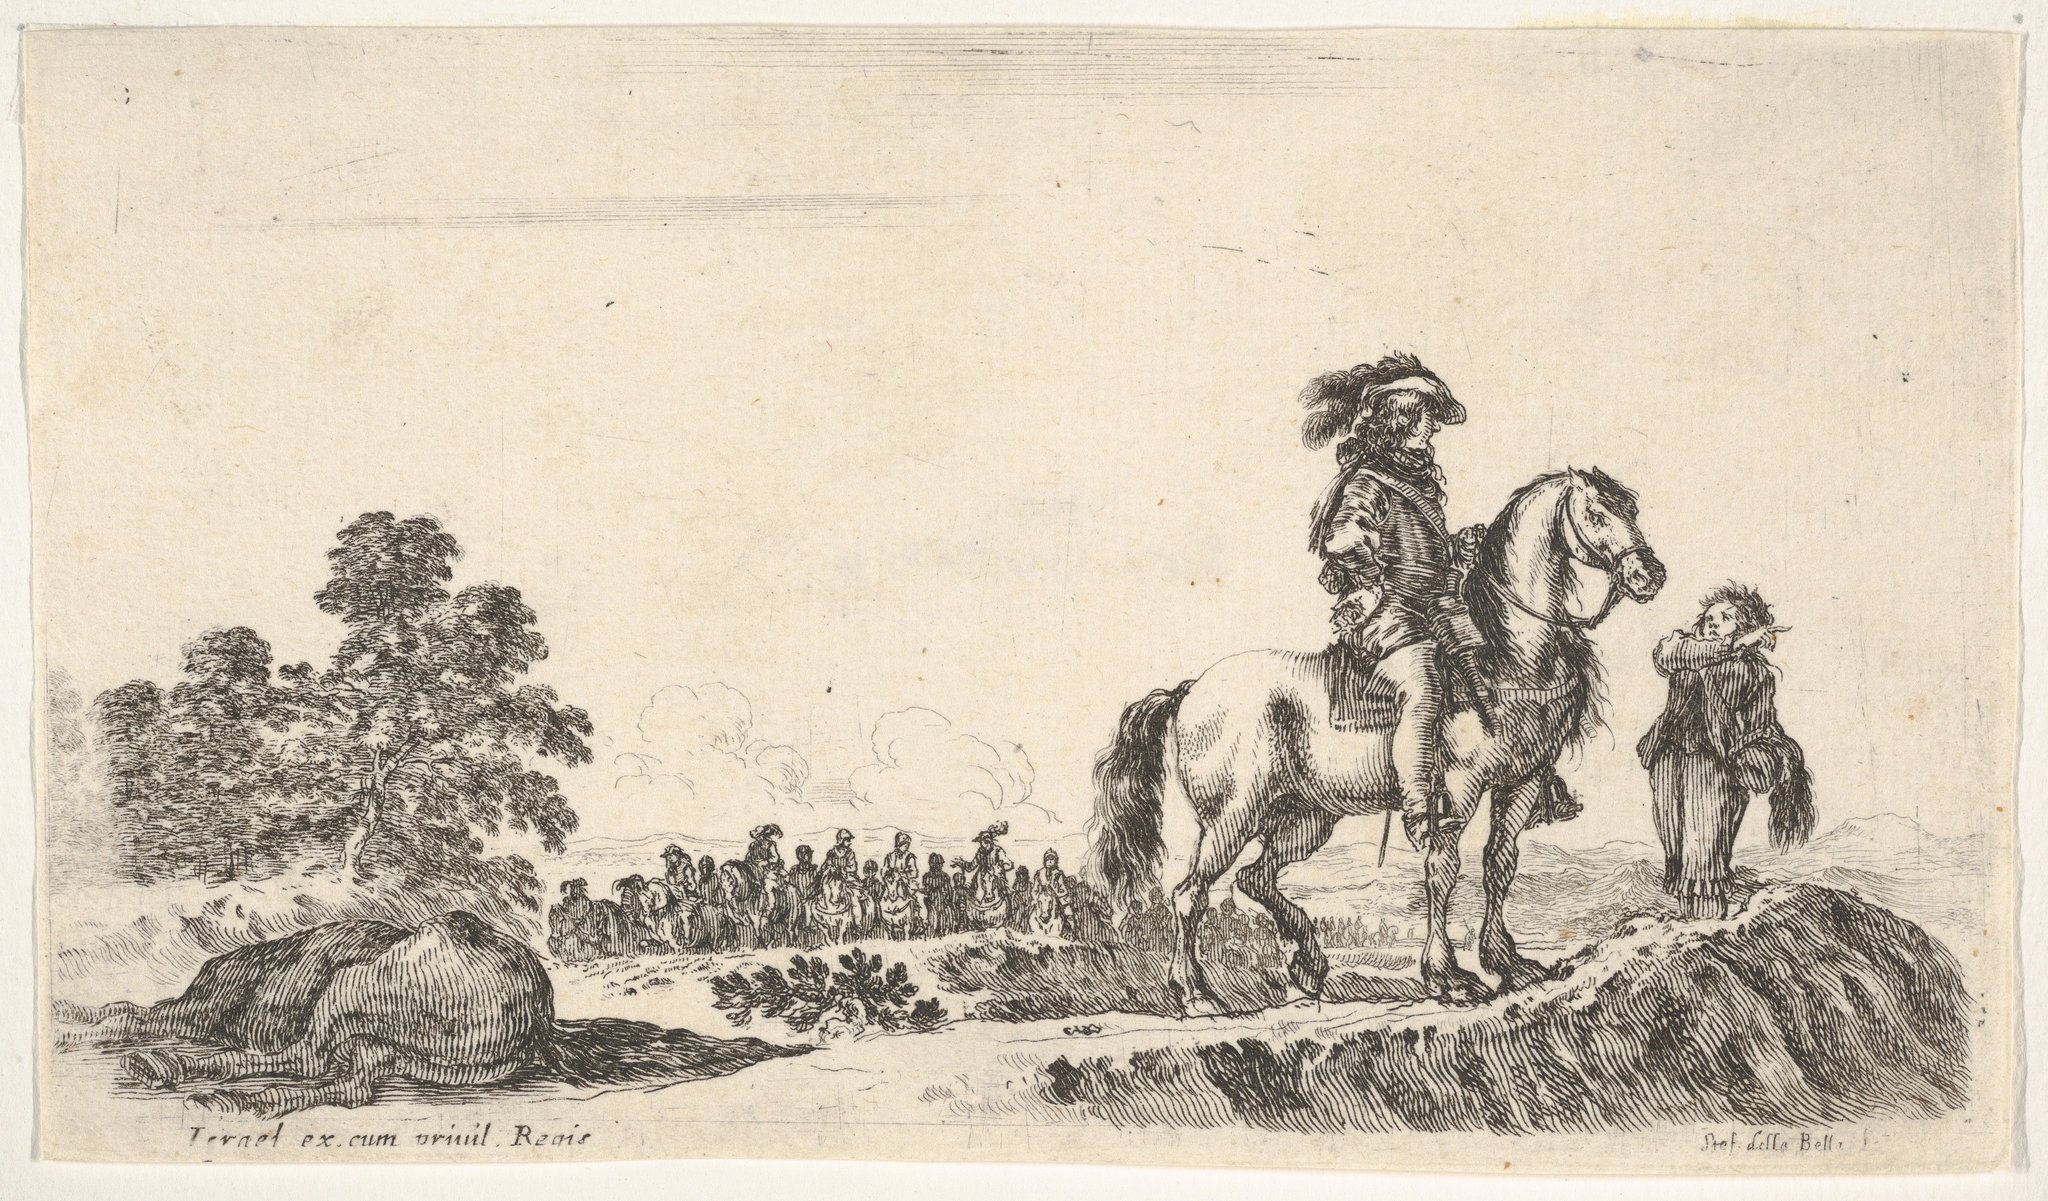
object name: print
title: A horseman facing right in profile asking a young man for directions, a dead horse to left, a group of horsemen to left in the background, from "Various figures and lands" (Diverse figure e paesi)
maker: stefano della bella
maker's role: artist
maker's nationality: italian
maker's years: 1610-1664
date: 1649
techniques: etching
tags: men,horses